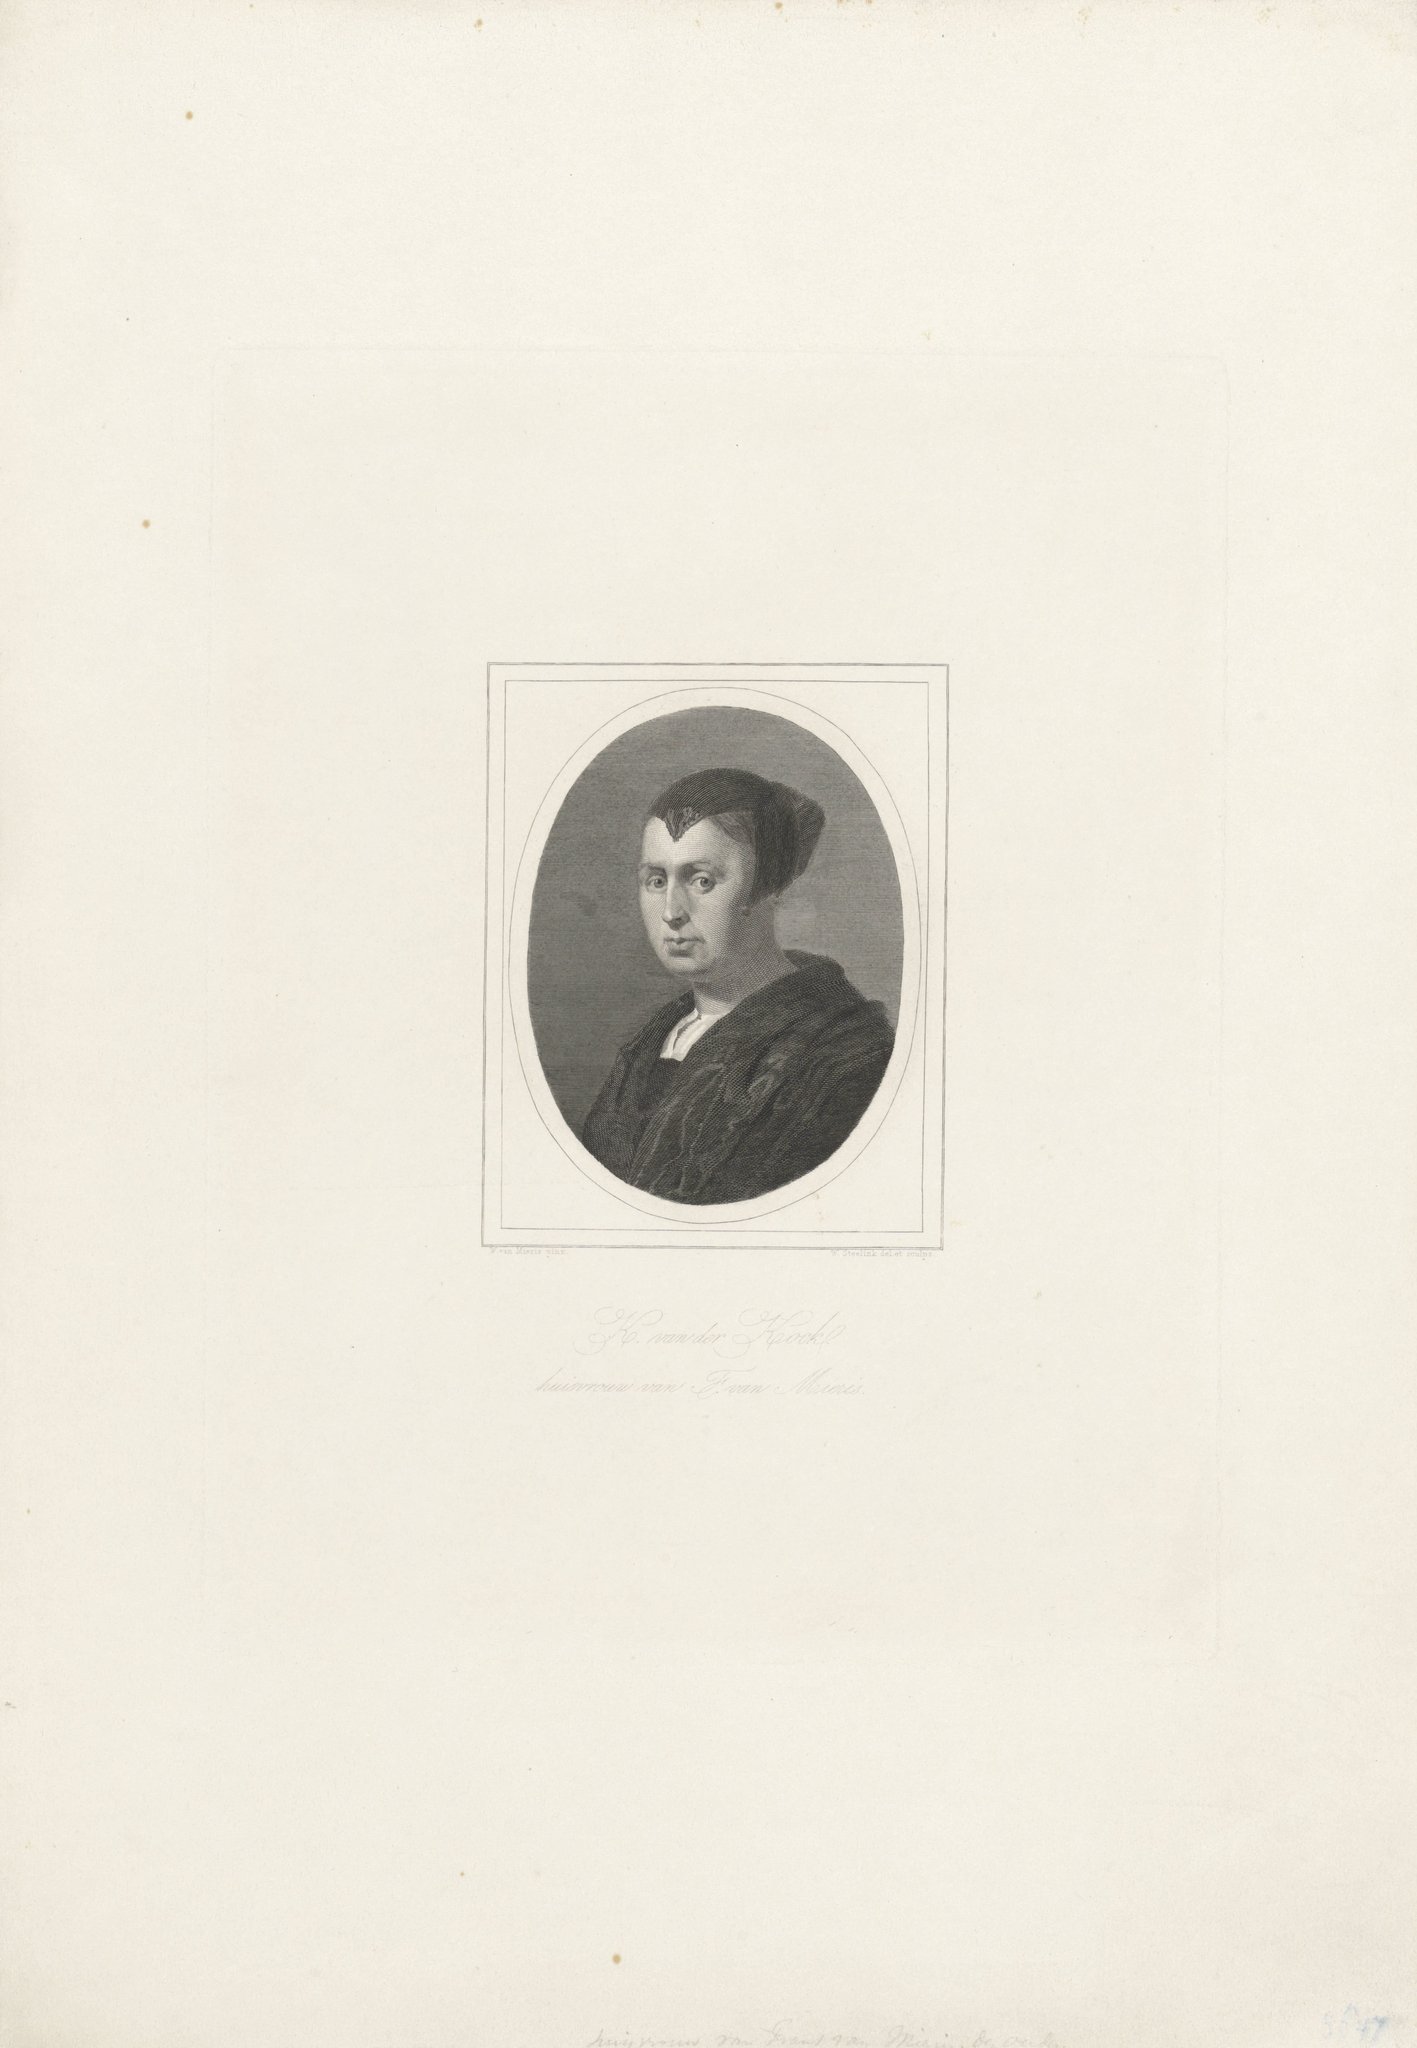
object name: print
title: Portret van Cunera van der Cock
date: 1836-1913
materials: paper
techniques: engraving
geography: amsterdam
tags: cunera van der cock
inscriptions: collector's mark: Lugt 2228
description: Portret van Cunera van der Cock, echtgenote van schilder Frans van Mieris (I).